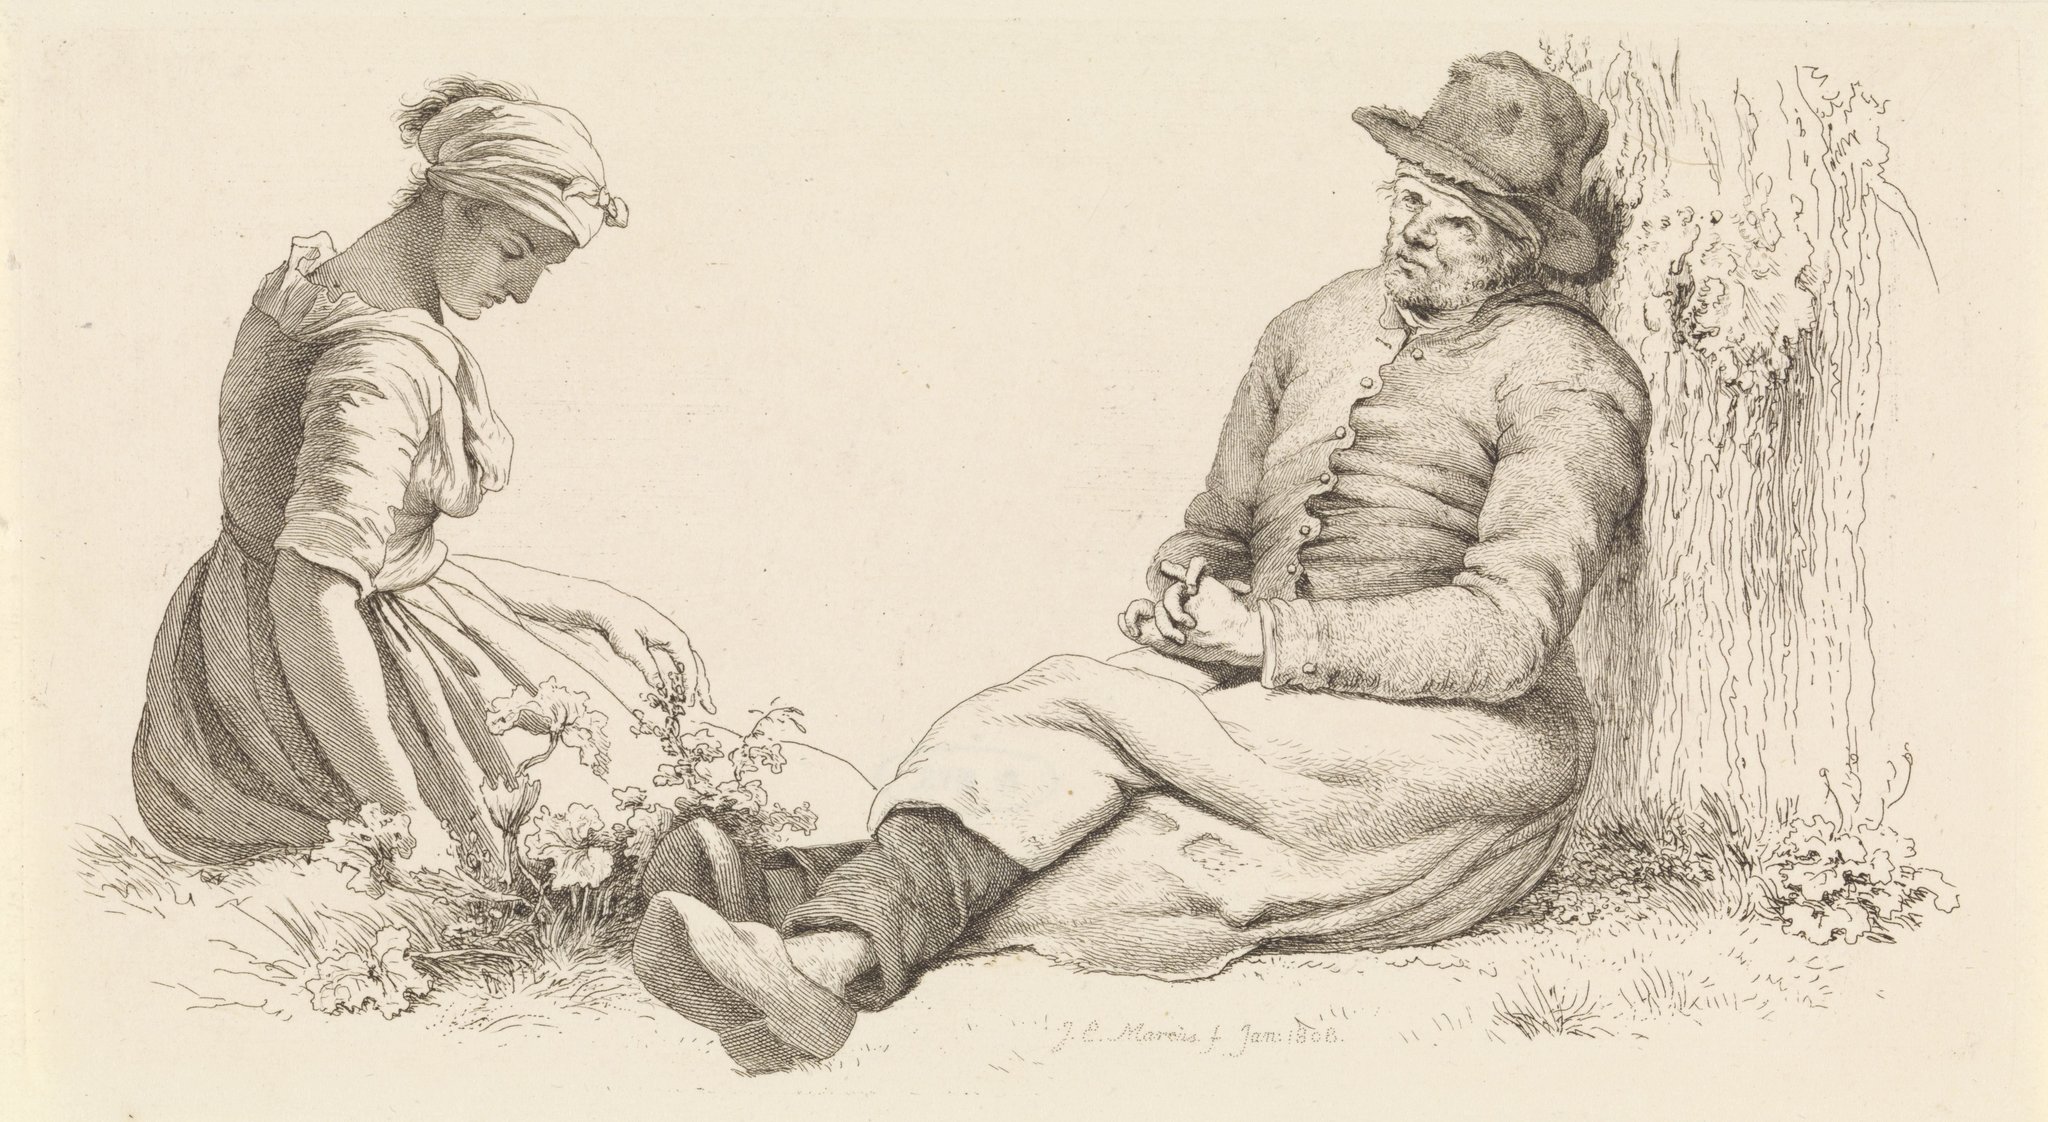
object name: print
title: Studieblad met een zittende man en een jonge vrouw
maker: jacob ernst marcus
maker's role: draughtsman, print maker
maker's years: 1774-1826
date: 1801-1808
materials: paper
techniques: etching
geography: amsterdam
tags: adolescent, young woman, maiden (+ sitting), old man (+ sitting)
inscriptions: collector's mark: Lugt 2228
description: Serie voor het eerst uitgegeven door Jacob Ernst Marcus onder de titel Studiebeelden en Fragmenten. Amsterdam: ca.1816. Later heruitgegeven als: Studie-prentwerk/ Etudes gravées.